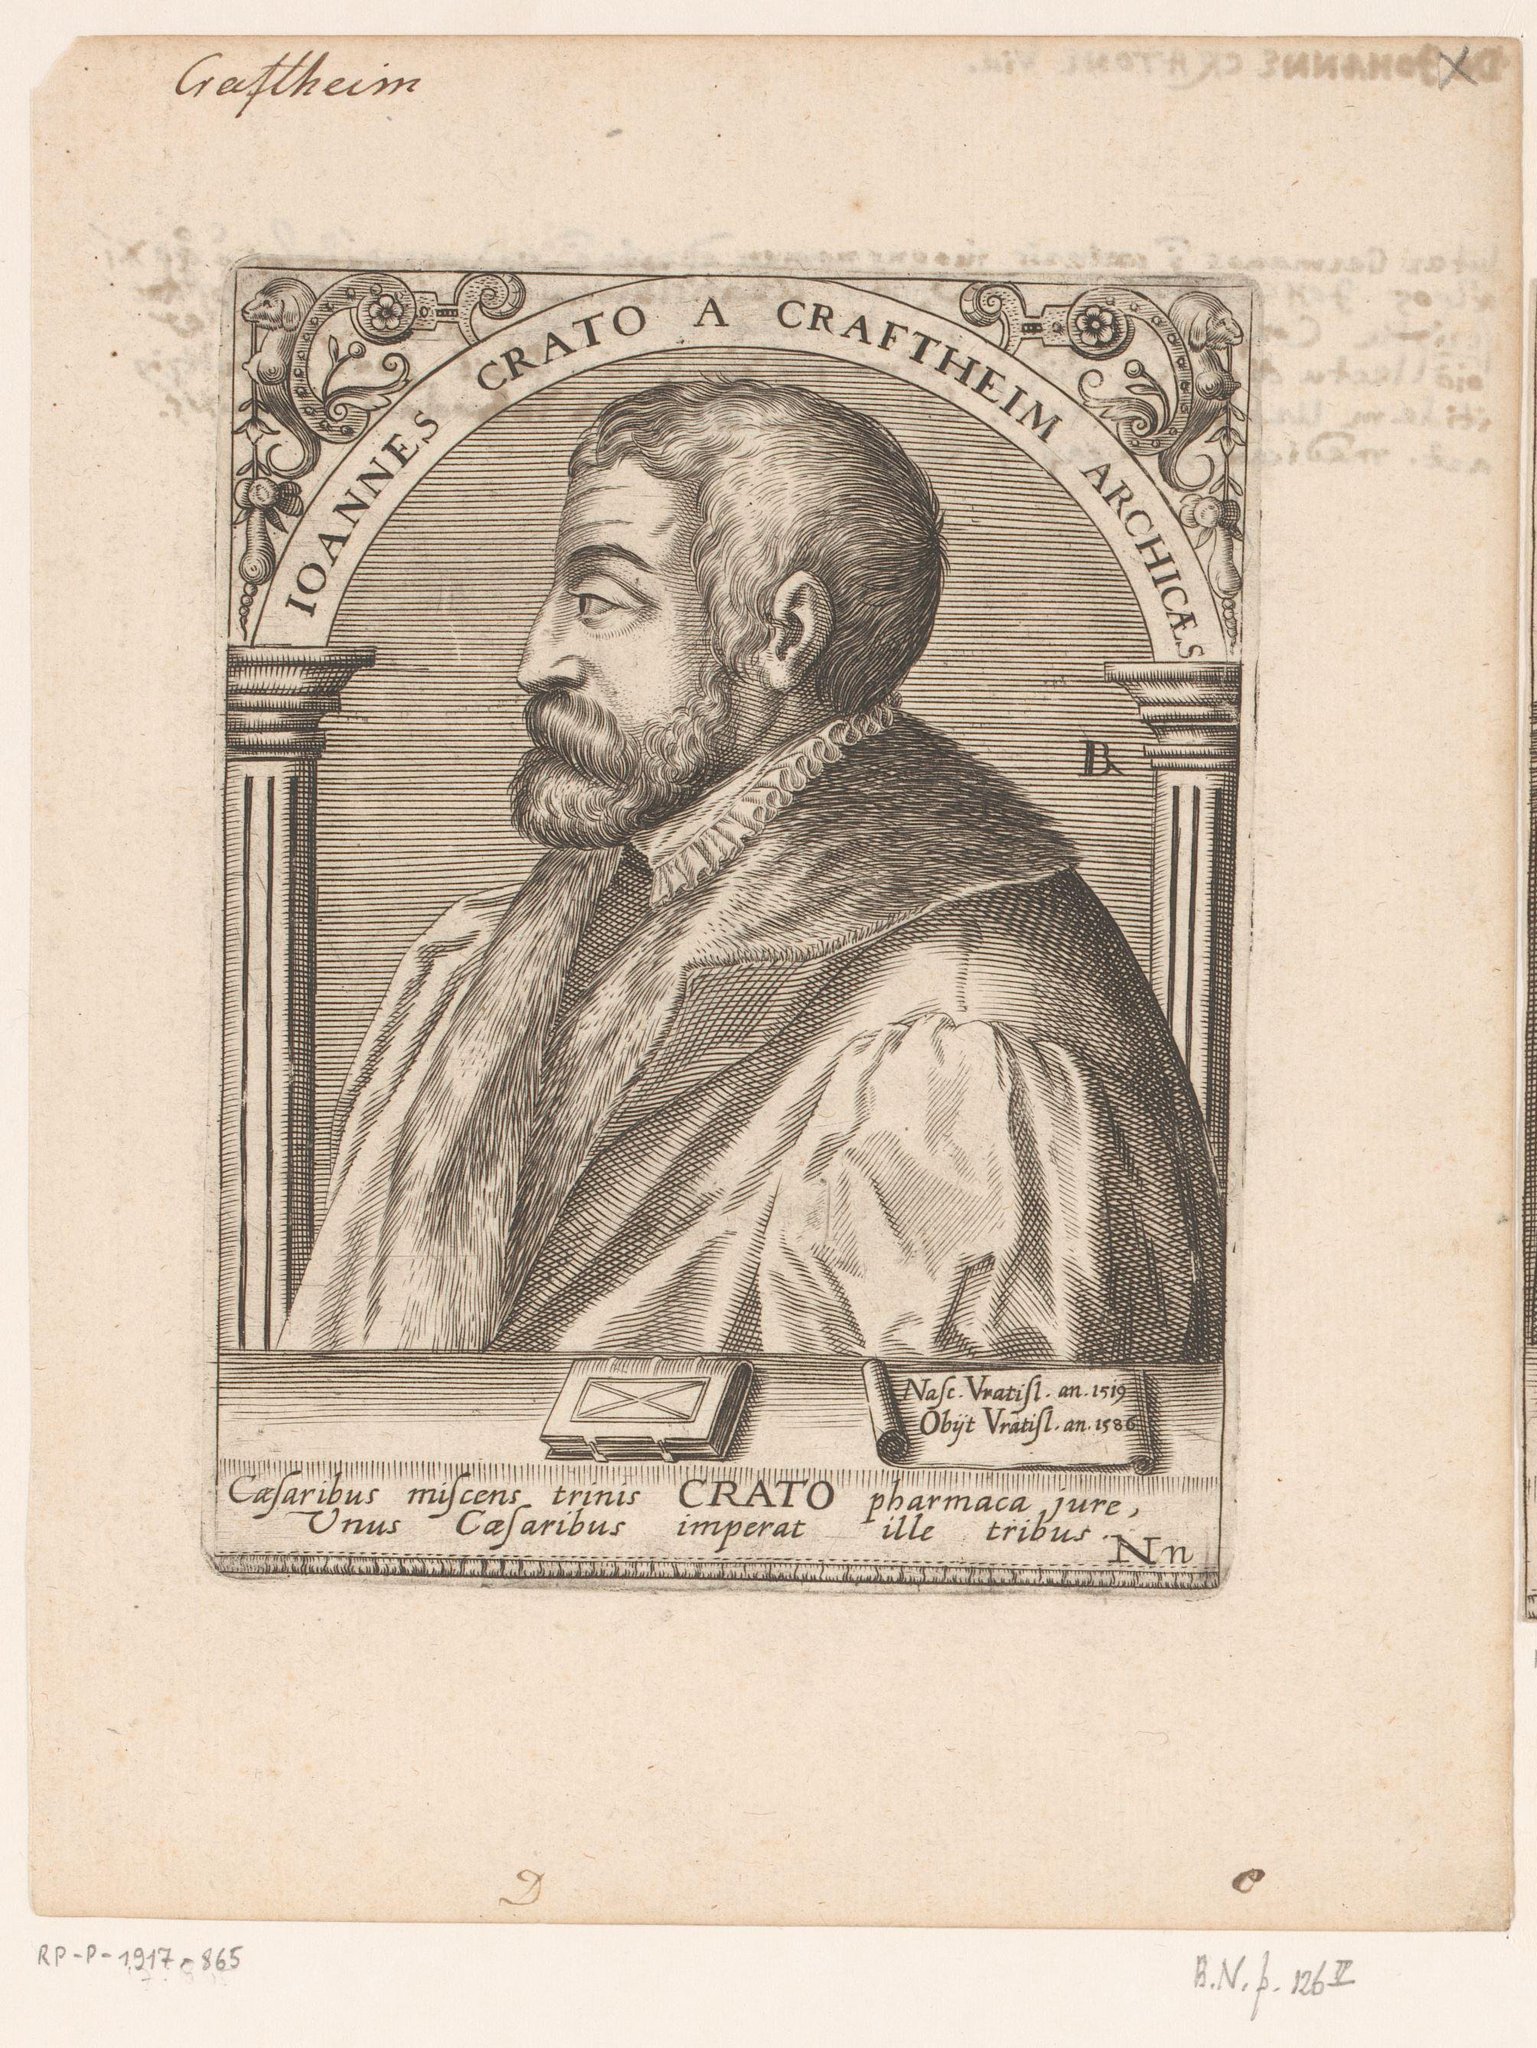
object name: print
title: Portretten van vredesonderhandelaars in Westfalen 1641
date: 1644-1671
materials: paper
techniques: engraving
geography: amsterdam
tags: historical persons, diplomacy, diplomat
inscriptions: collector's mark: Lugt 2228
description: Prent maakt deel uit van een serie van 43 prenten. Eerdere staat van prent gebruikt in de serie 'Icones legatorum Monasterii et Osnabrugae existentium', uitgegeven door Abraham van Waesbergen in Amsterdam.